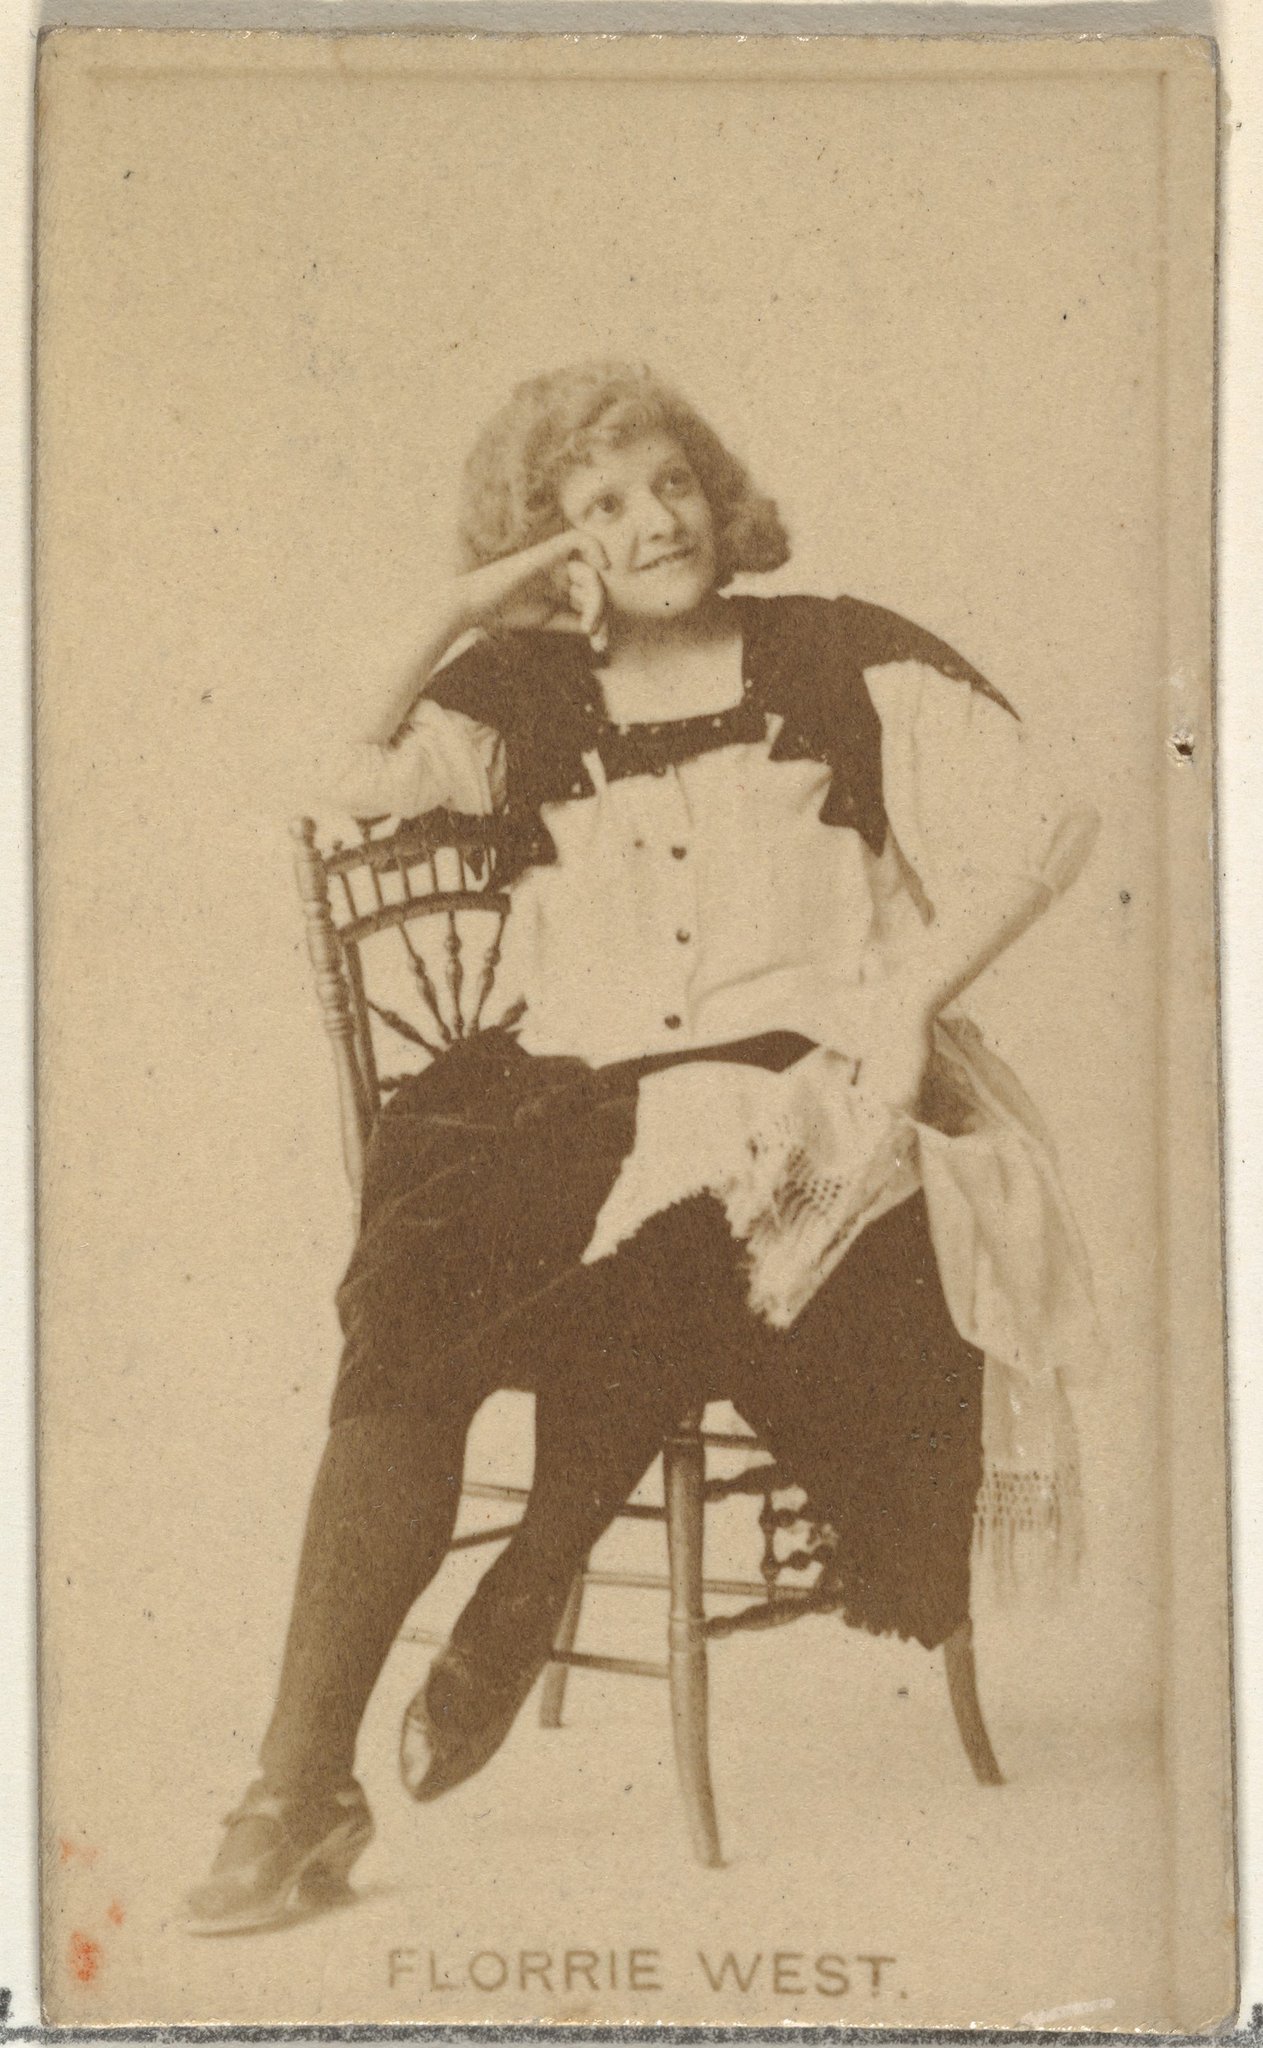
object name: photograph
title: Florrie West, from the Actors and Actresses series (N145-8) issued by Duke Sons & Co. to promote Duke Cigarettes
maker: w. duke, sons & co.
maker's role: publisher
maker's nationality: american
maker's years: 1870-1920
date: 1891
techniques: albumen silver print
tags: portraits,women,actresses